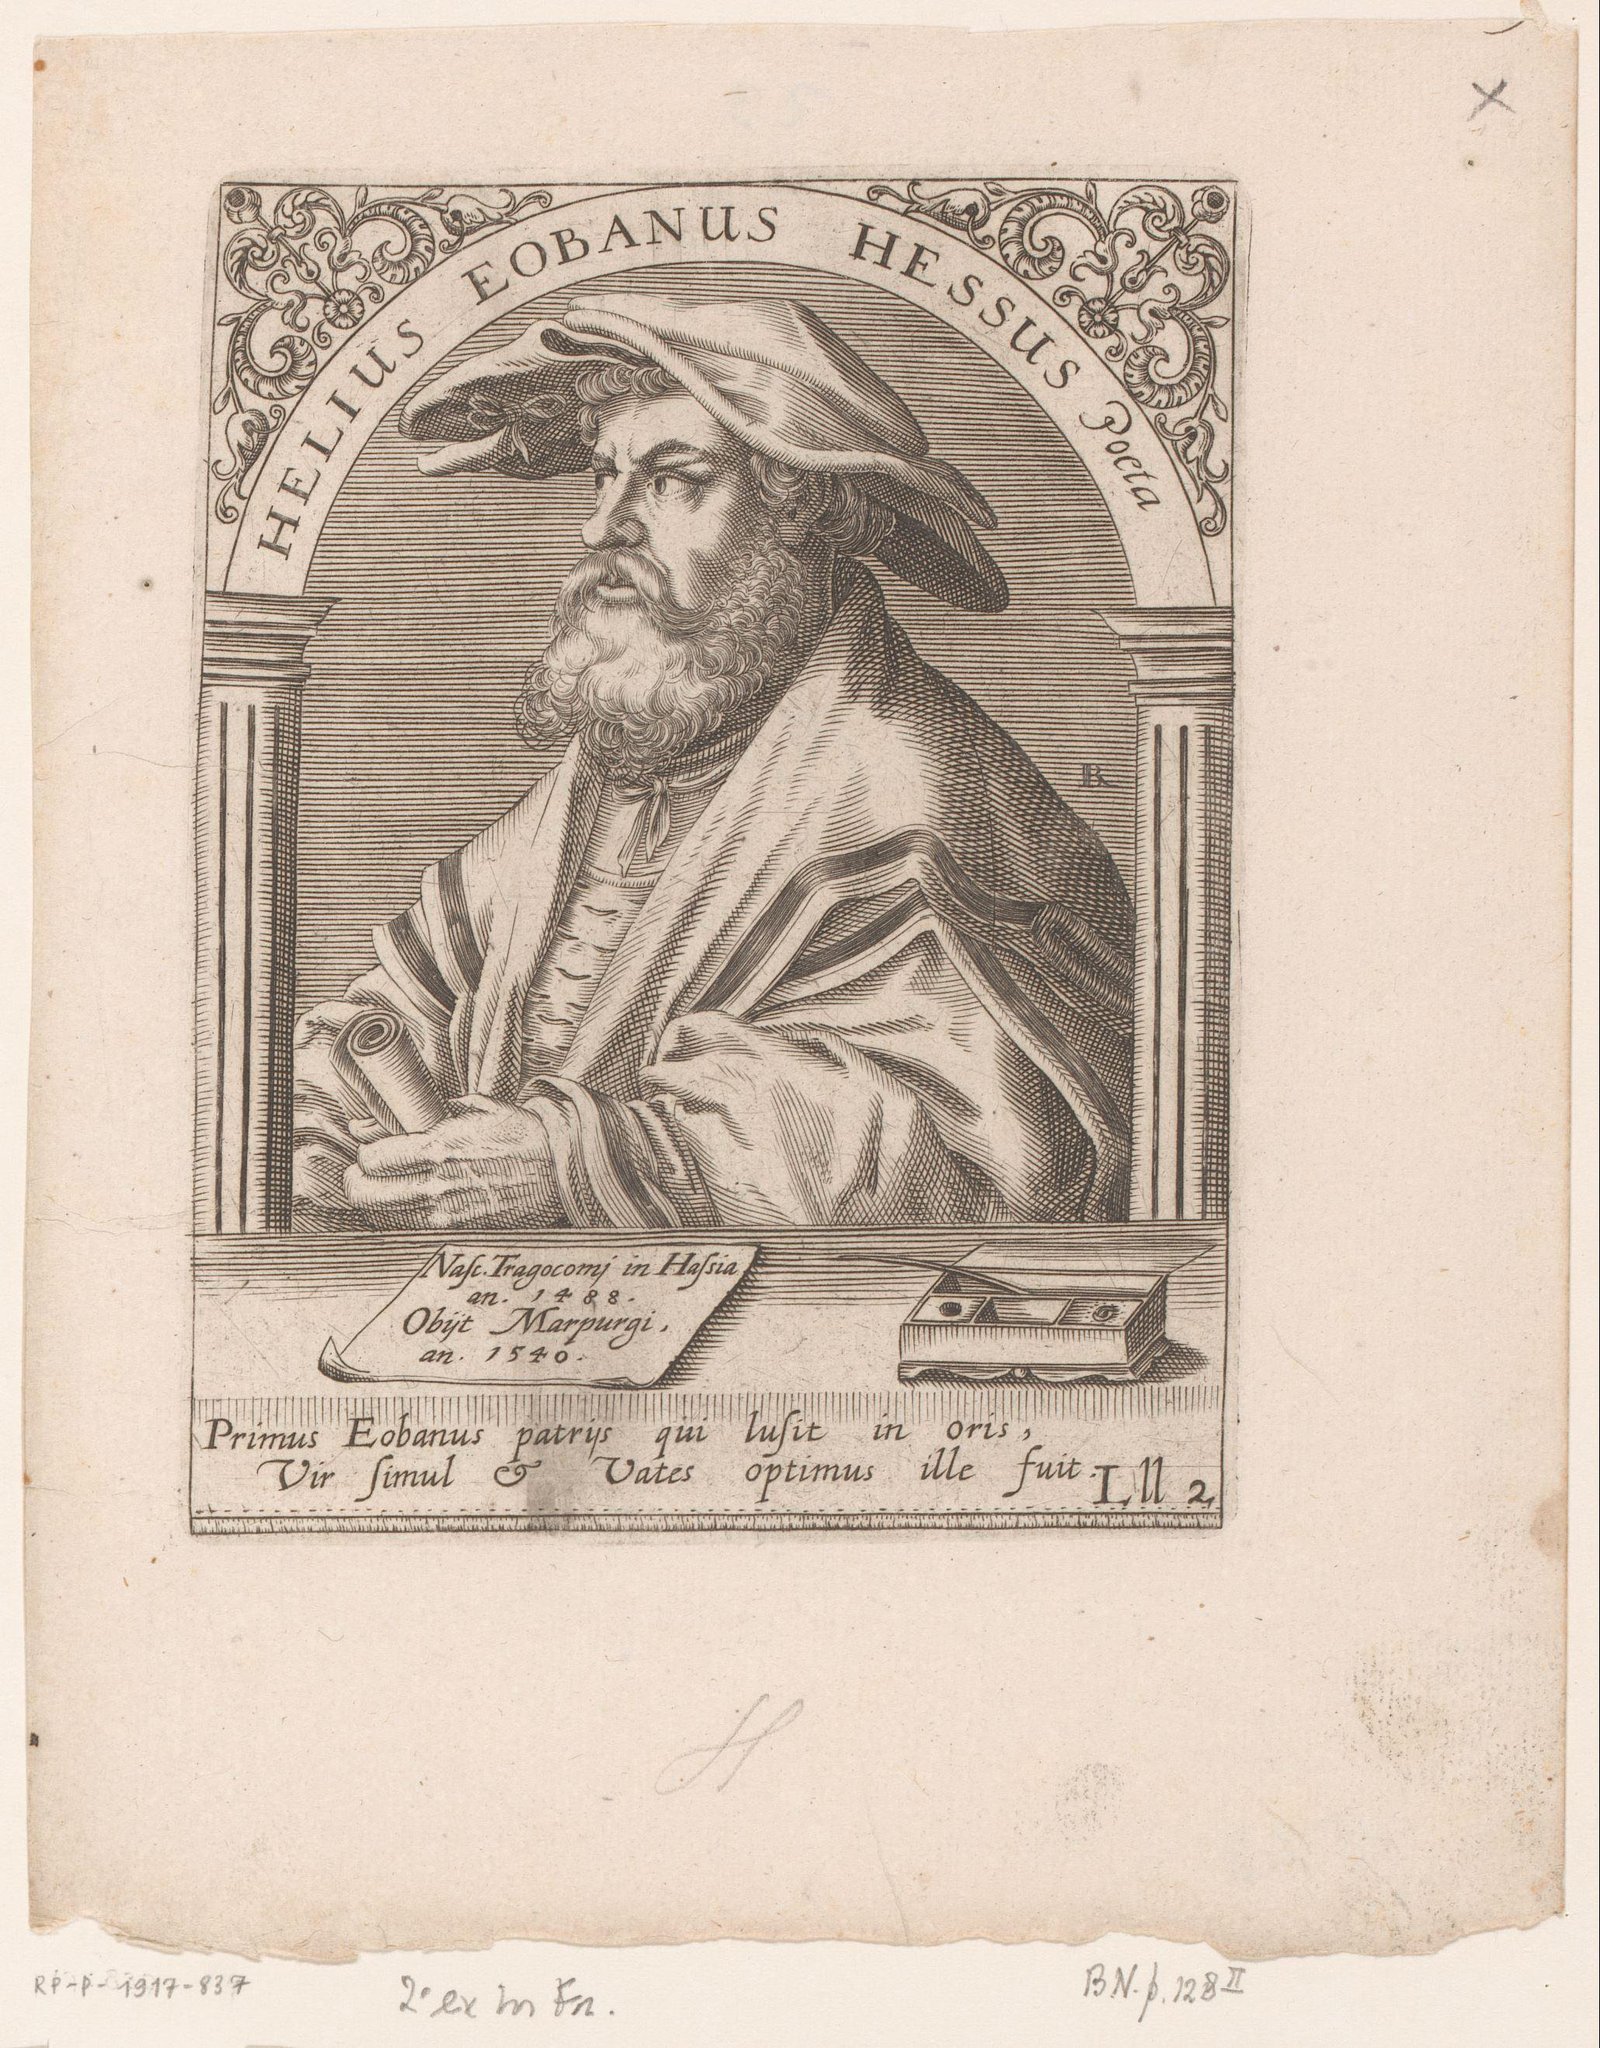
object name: print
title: Serie portretten van vijftiende- en zestiende-eeuwse geleerden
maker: robert boissard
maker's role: print maker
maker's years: 1570-1611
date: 1597-1599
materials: paper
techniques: engraving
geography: france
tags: helius eobanus hessus, ink-well, historical persons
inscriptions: collector's mark: Lugt 2228